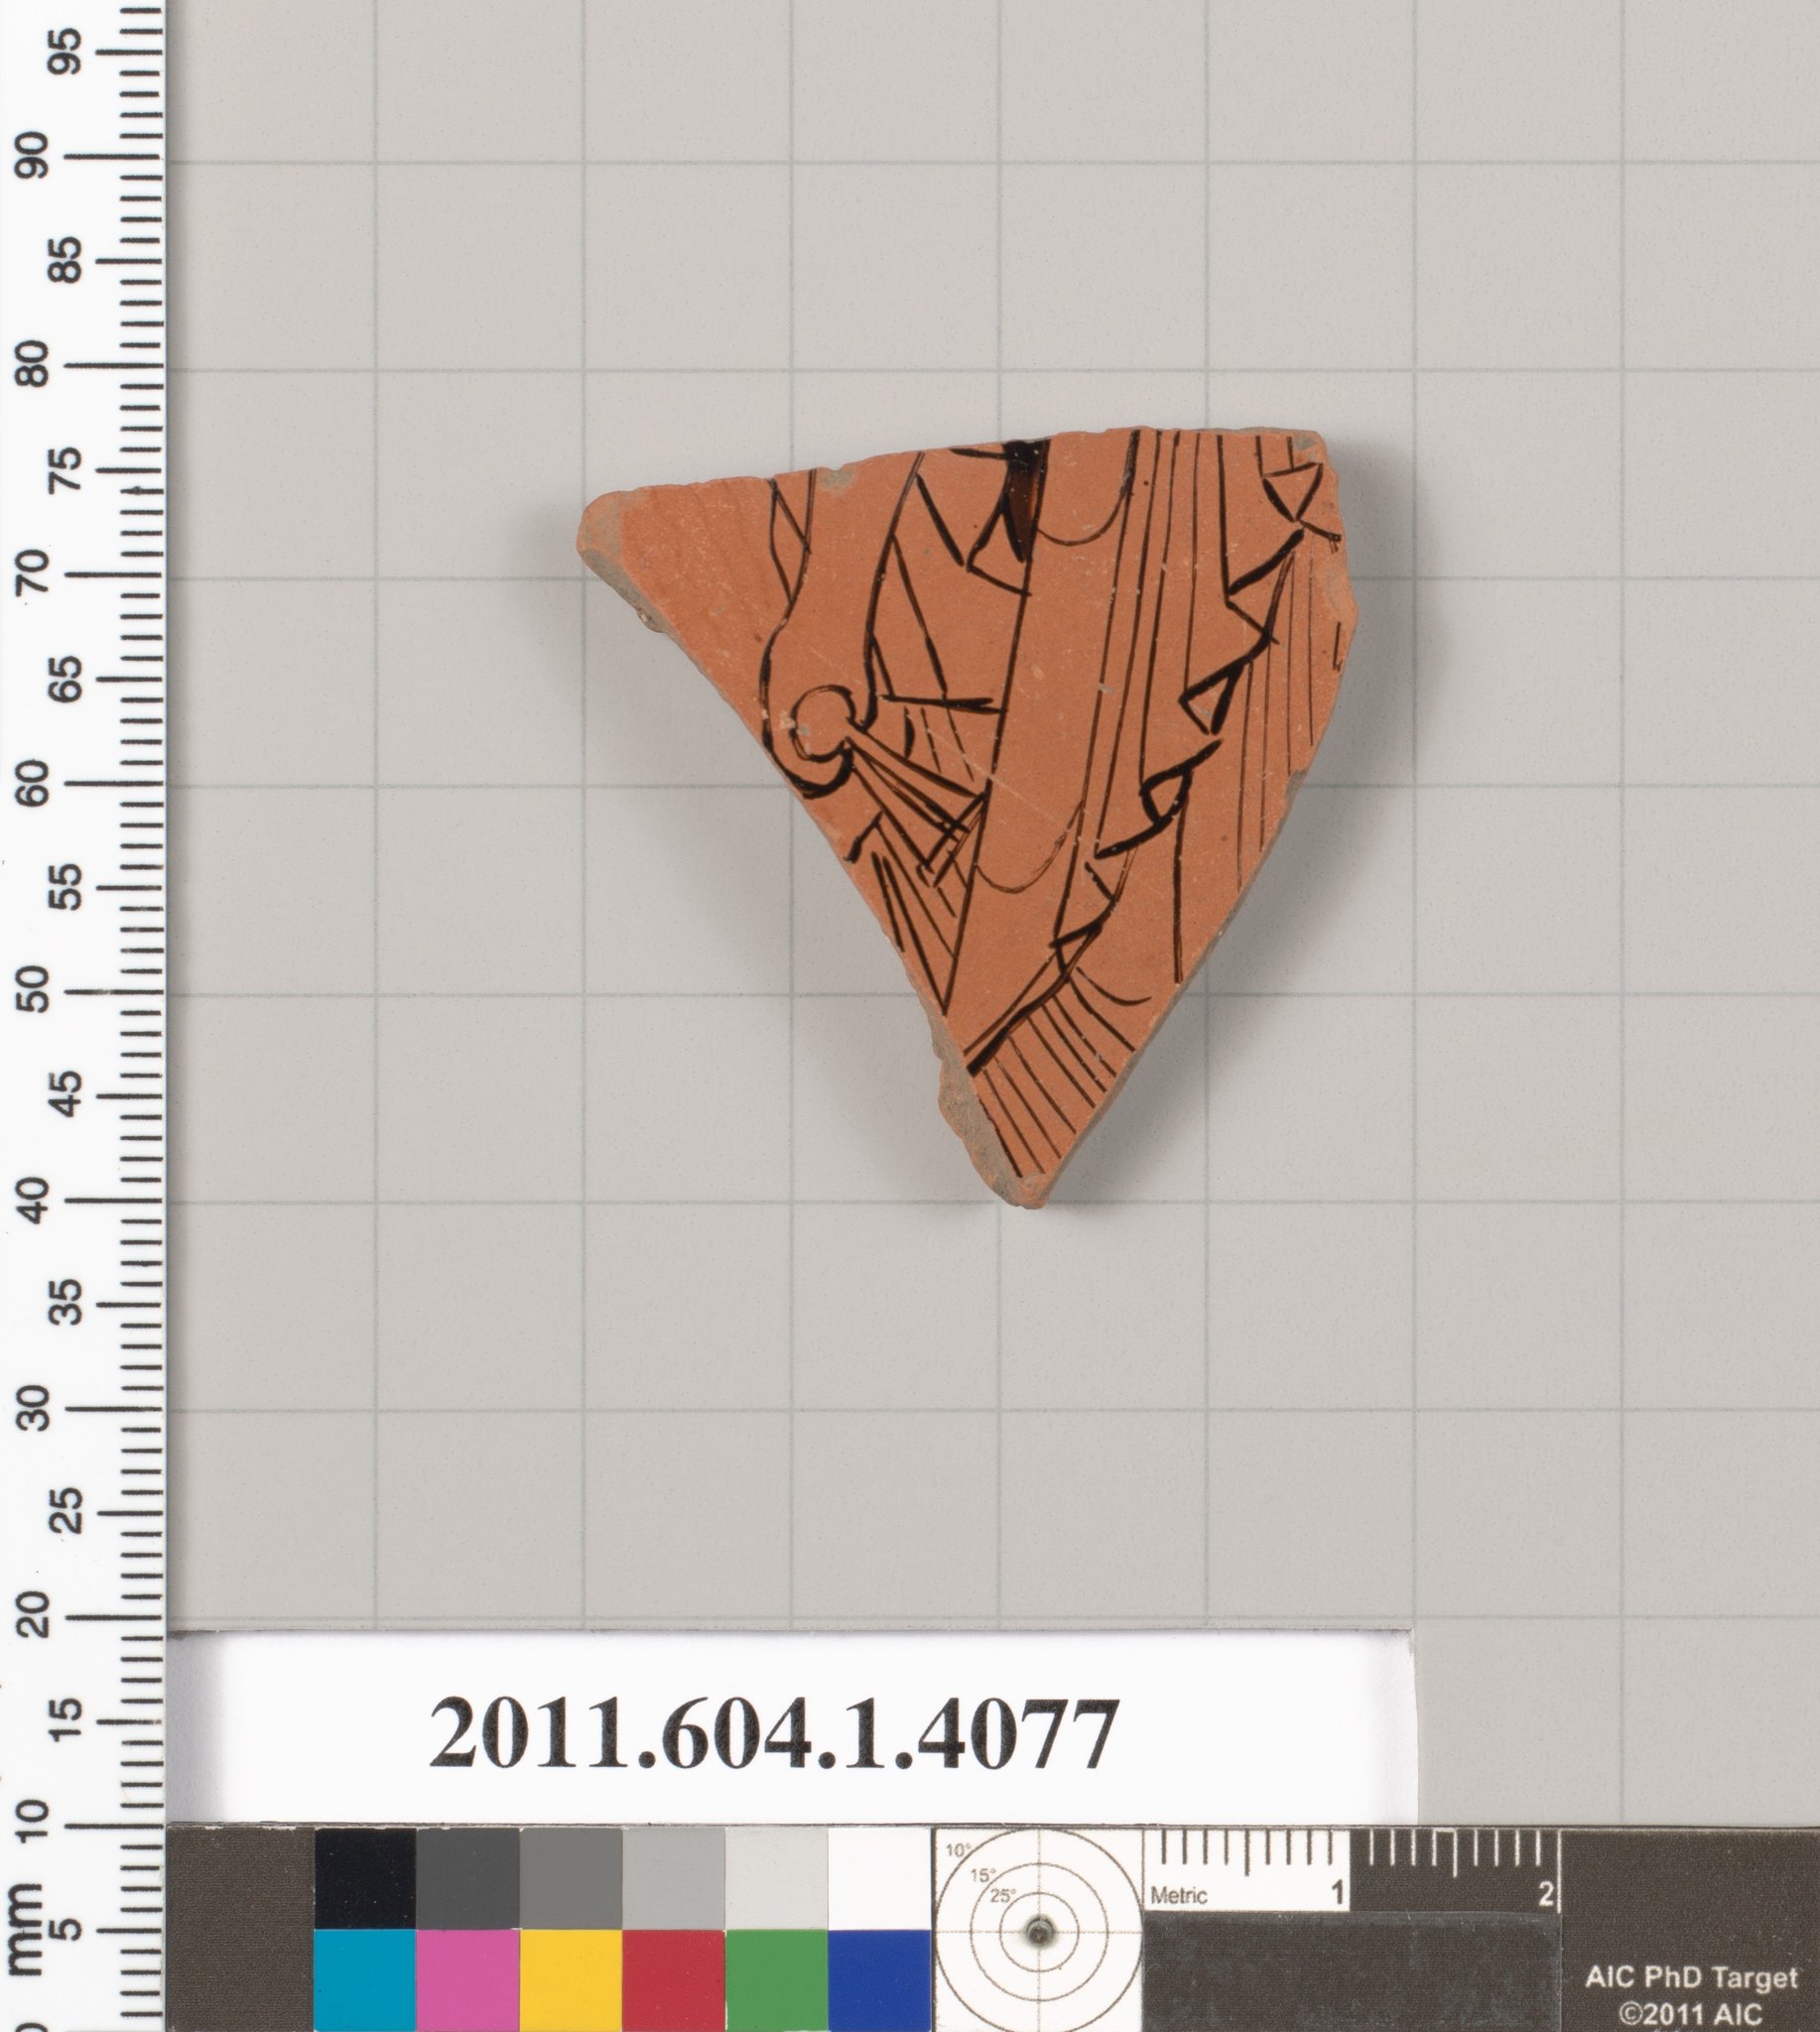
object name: kylix fragment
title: Terracotta fragment of a kylix (drinking cup)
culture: greek, attic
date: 490-480 BCE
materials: terracotta